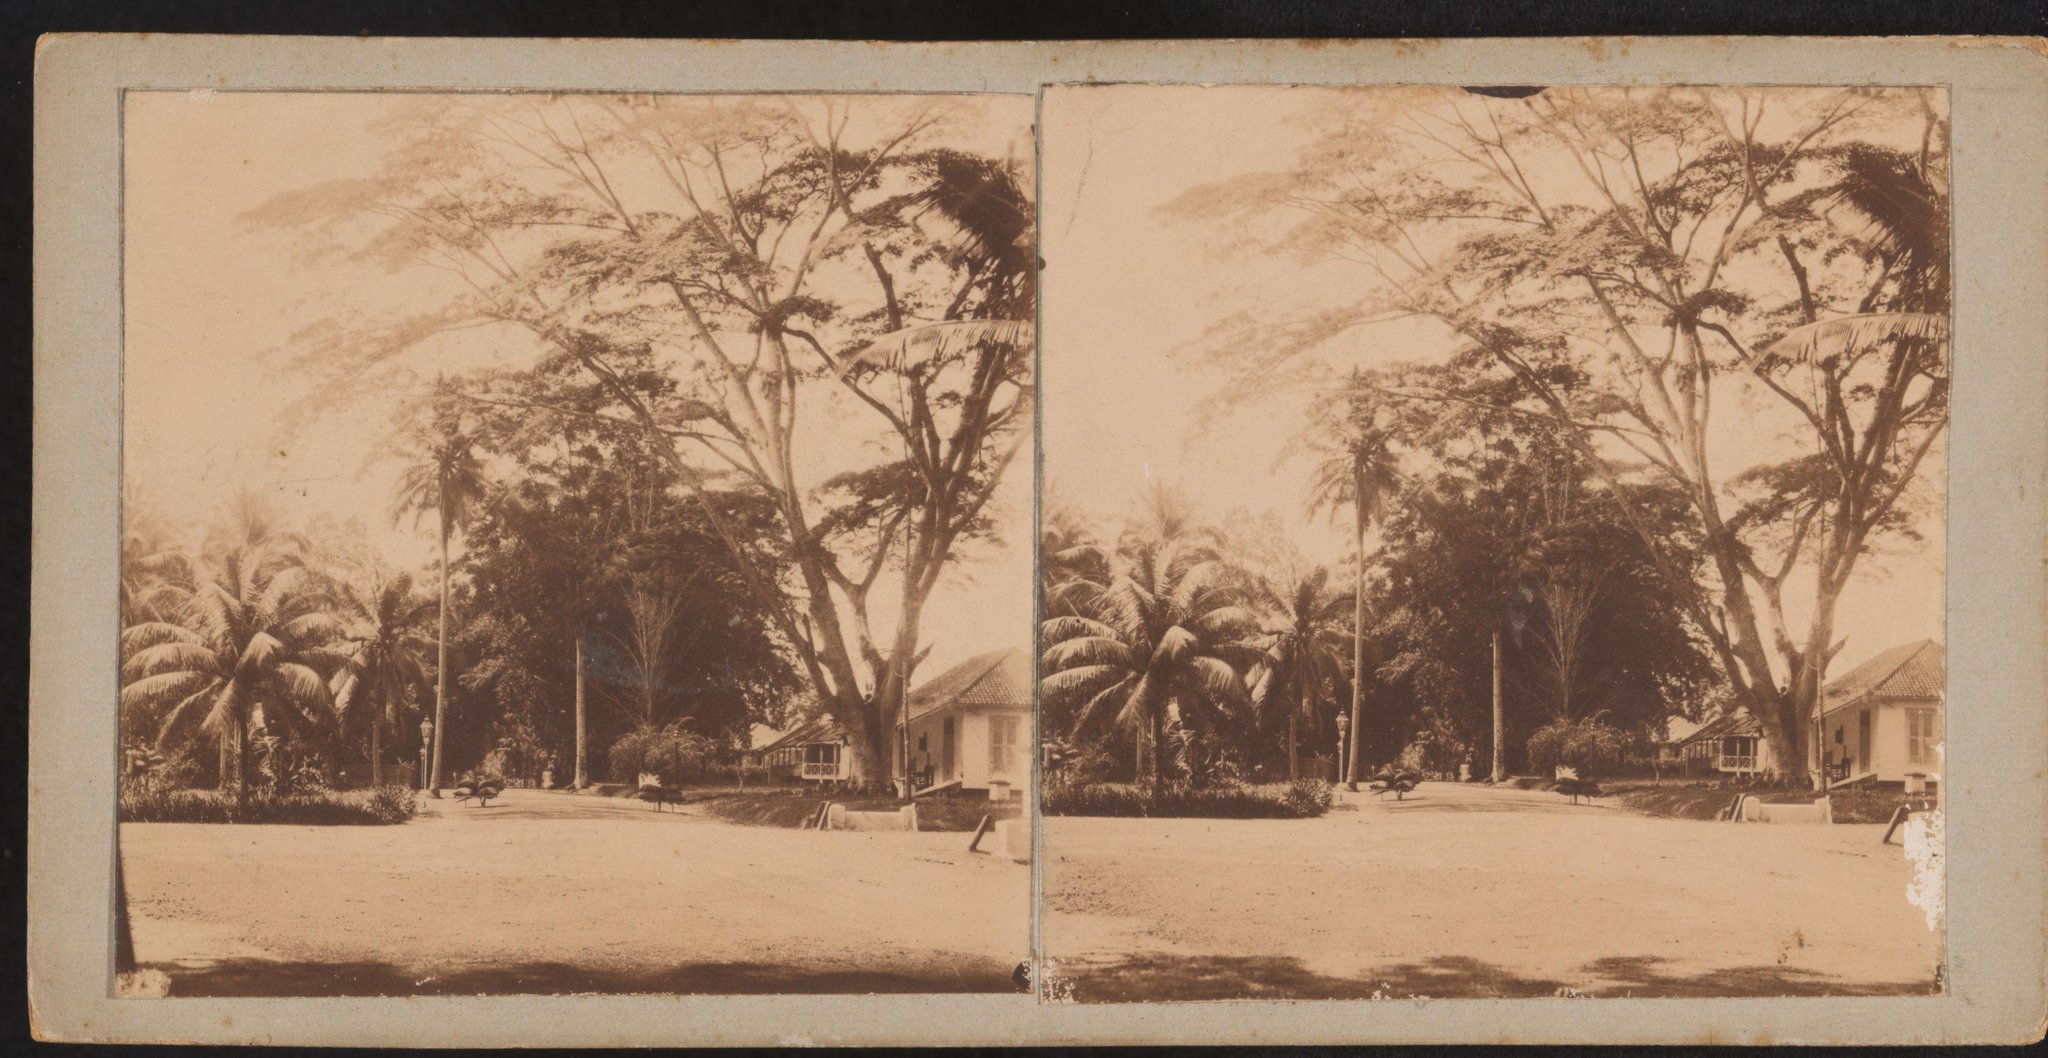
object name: stereograph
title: Gezicht te Soengeiliat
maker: robert julius boers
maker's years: 1867-1932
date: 1900-1922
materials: cardboard, photographic support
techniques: gelatin silver print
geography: bangka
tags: robert julius boers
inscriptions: inscription: ‘Soengei keiat Rechts Passang Grahan en kantoor Administrateur’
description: Gezicht langs de weg te Soengeiliat, rechts de pasanggrahan en het administratiekantoor. Onderdeel van een groep stereofoto's van Robert Julius Boers, chef van het staatsbedrijf de Banka-tinwinning op Banka, uit de periode ca. 1900-1922.